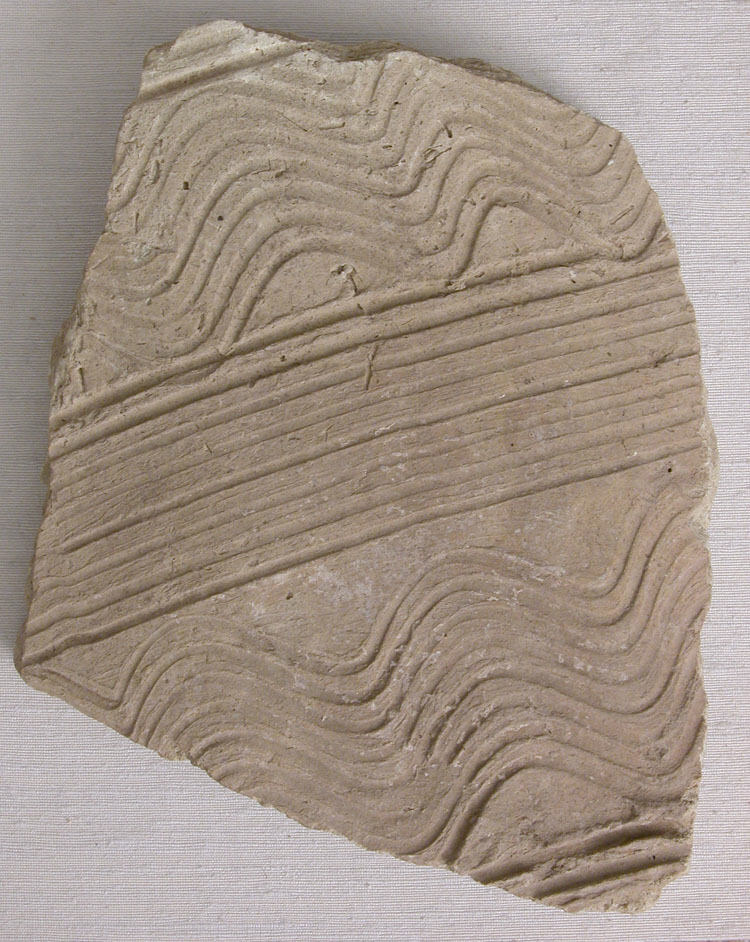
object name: fragment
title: Ceramic Fragment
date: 701-900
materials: earthenware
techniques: stamping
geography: iraq